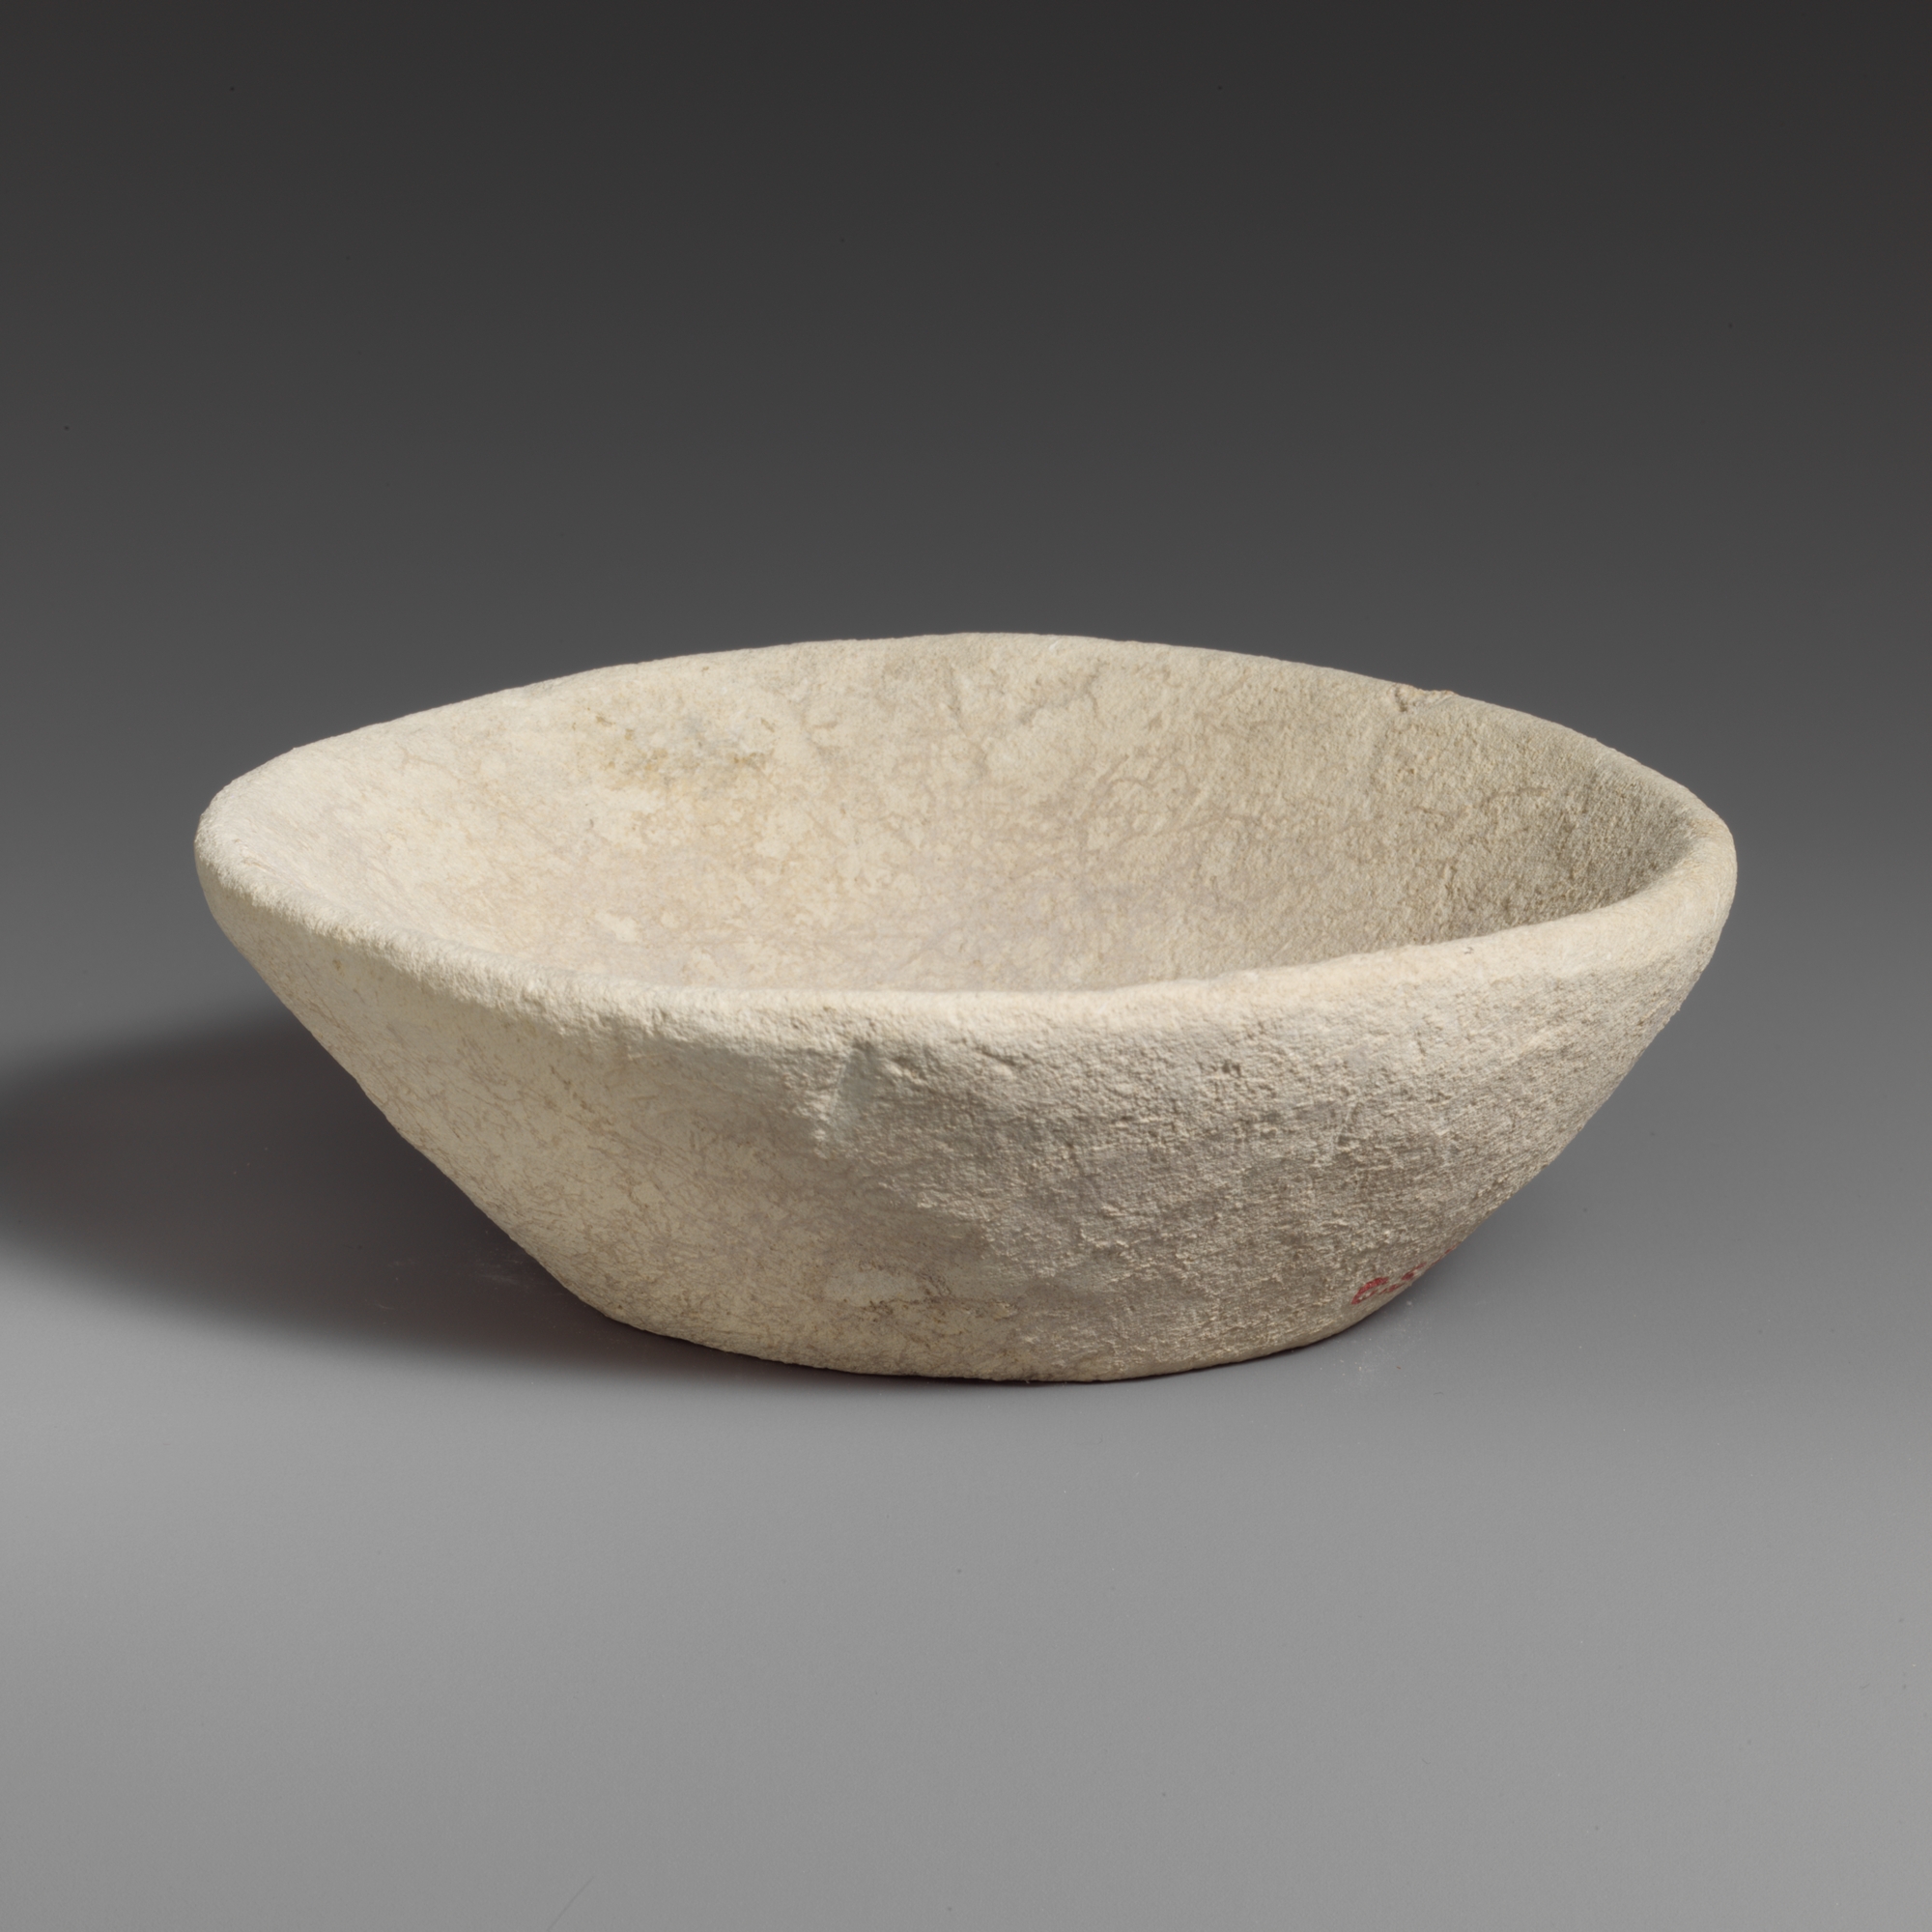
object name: bowl, shallow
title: Limestone bowl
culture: cypriot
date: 3900 BCE-100 CE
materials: limestone